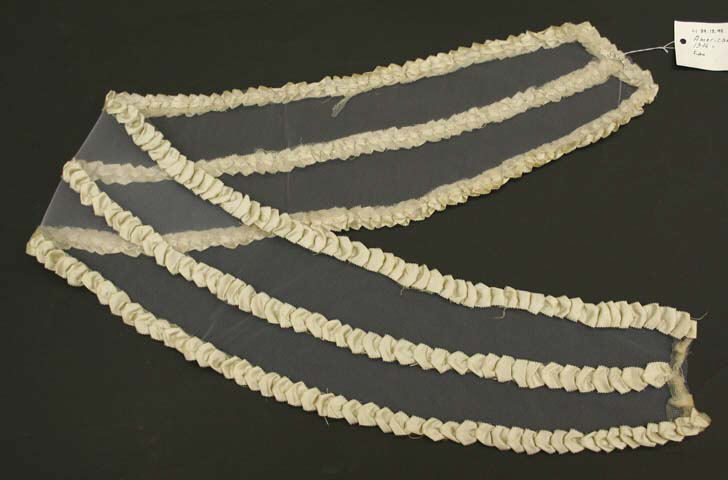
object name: fichu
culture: european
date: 1799-1821